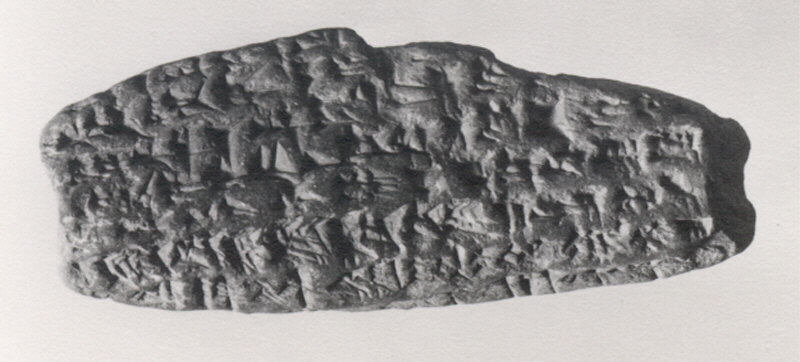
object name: cuneiform tablet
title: Cuneiform tablet: fragment of a promissory note, Egibi archive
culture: achaemenid or babylonian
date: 600-501 BCE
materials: clay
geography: mesopotamia